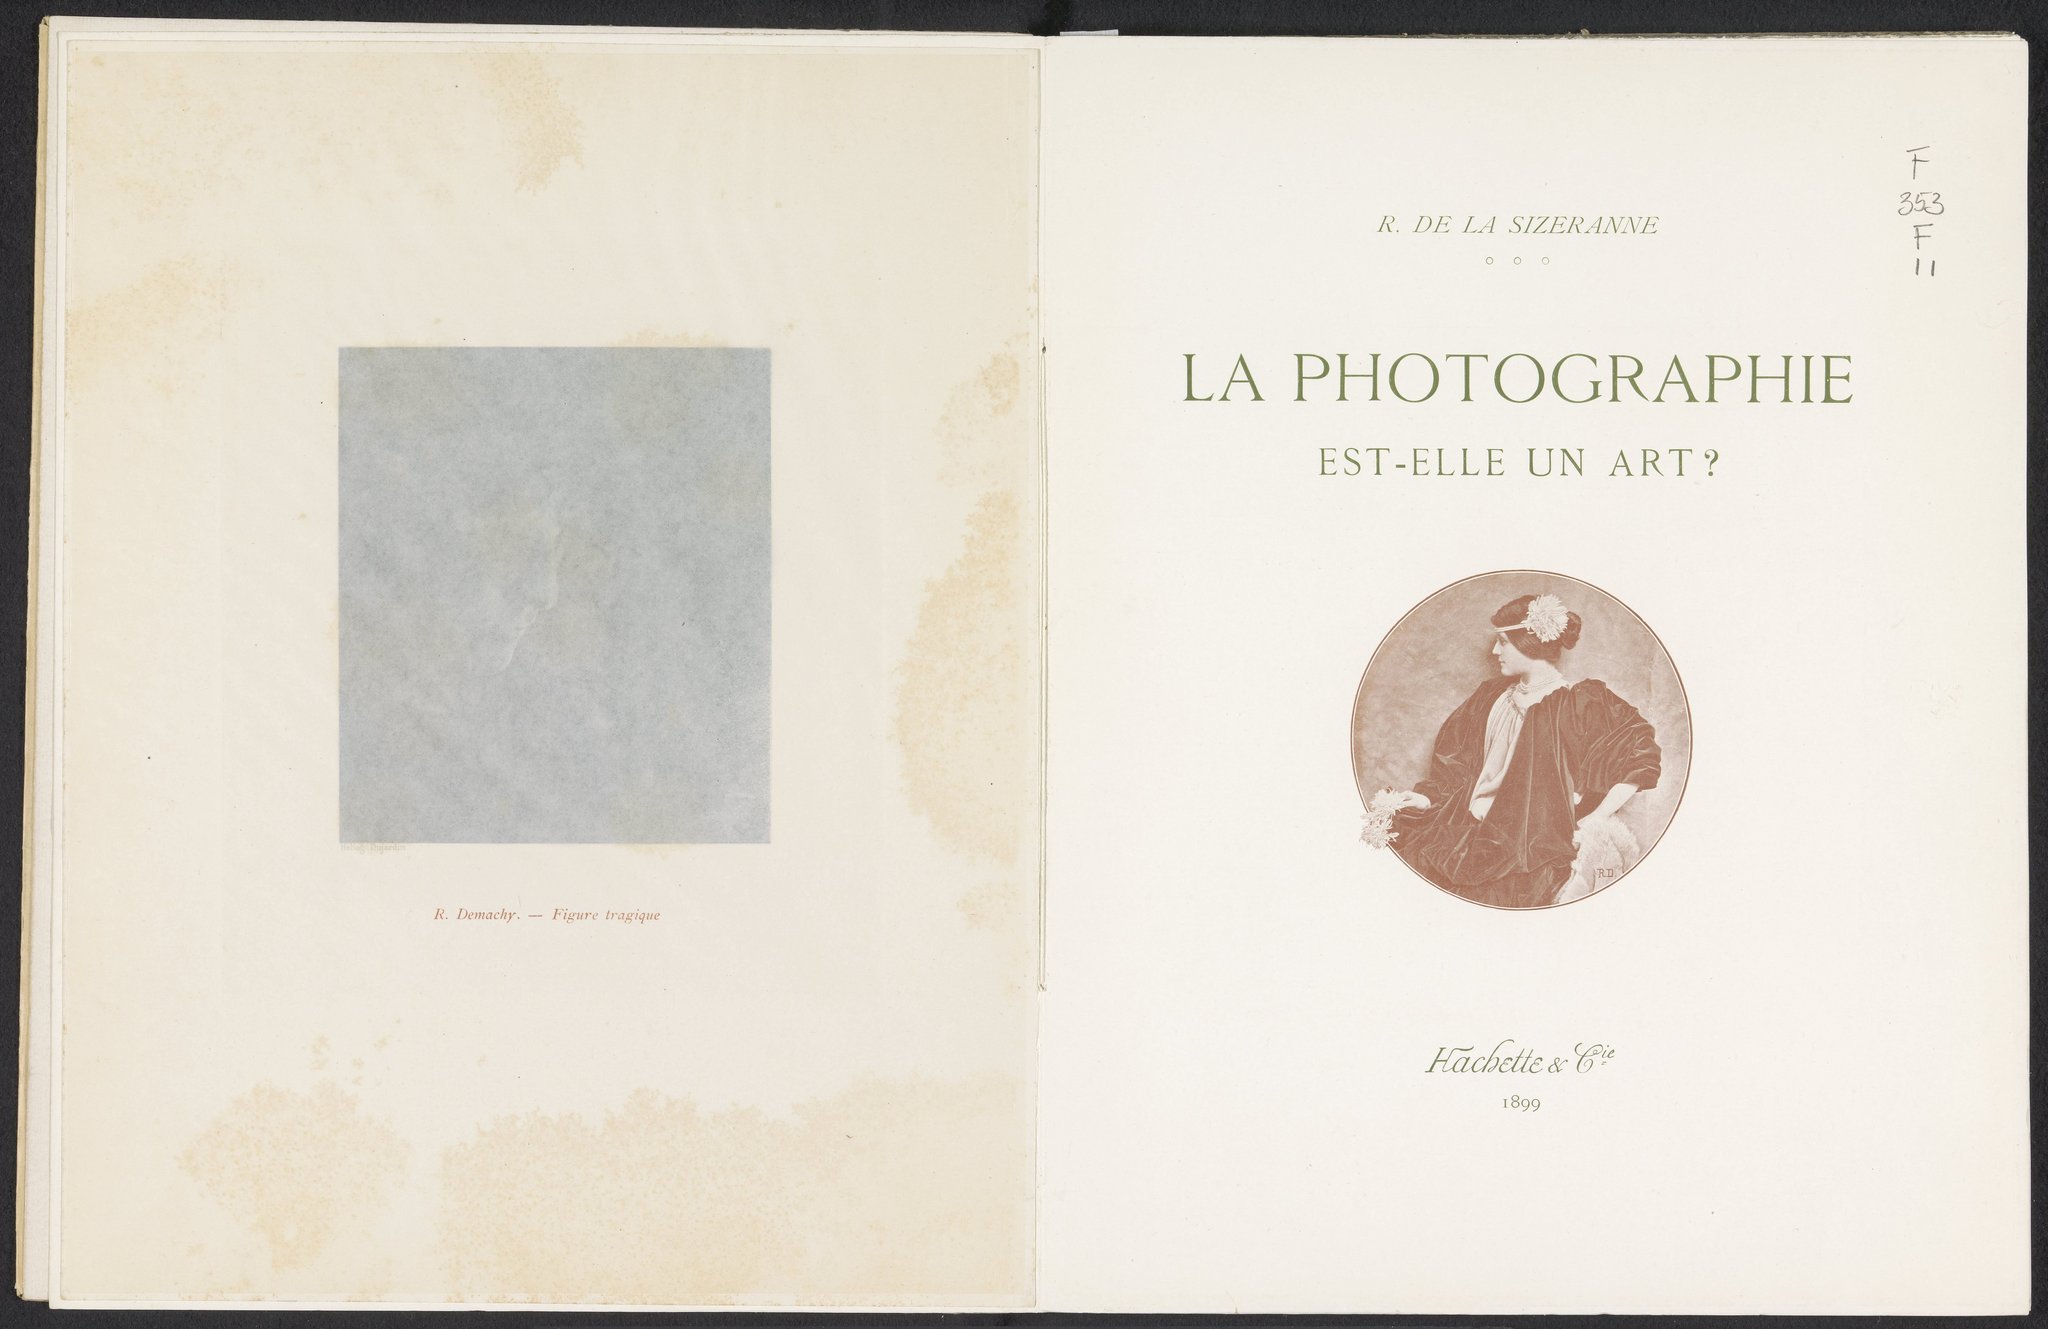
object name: photomechanical print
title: Portret van een onbekende vrouw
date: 1889-1899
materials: paper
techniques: autotype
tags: adult woman